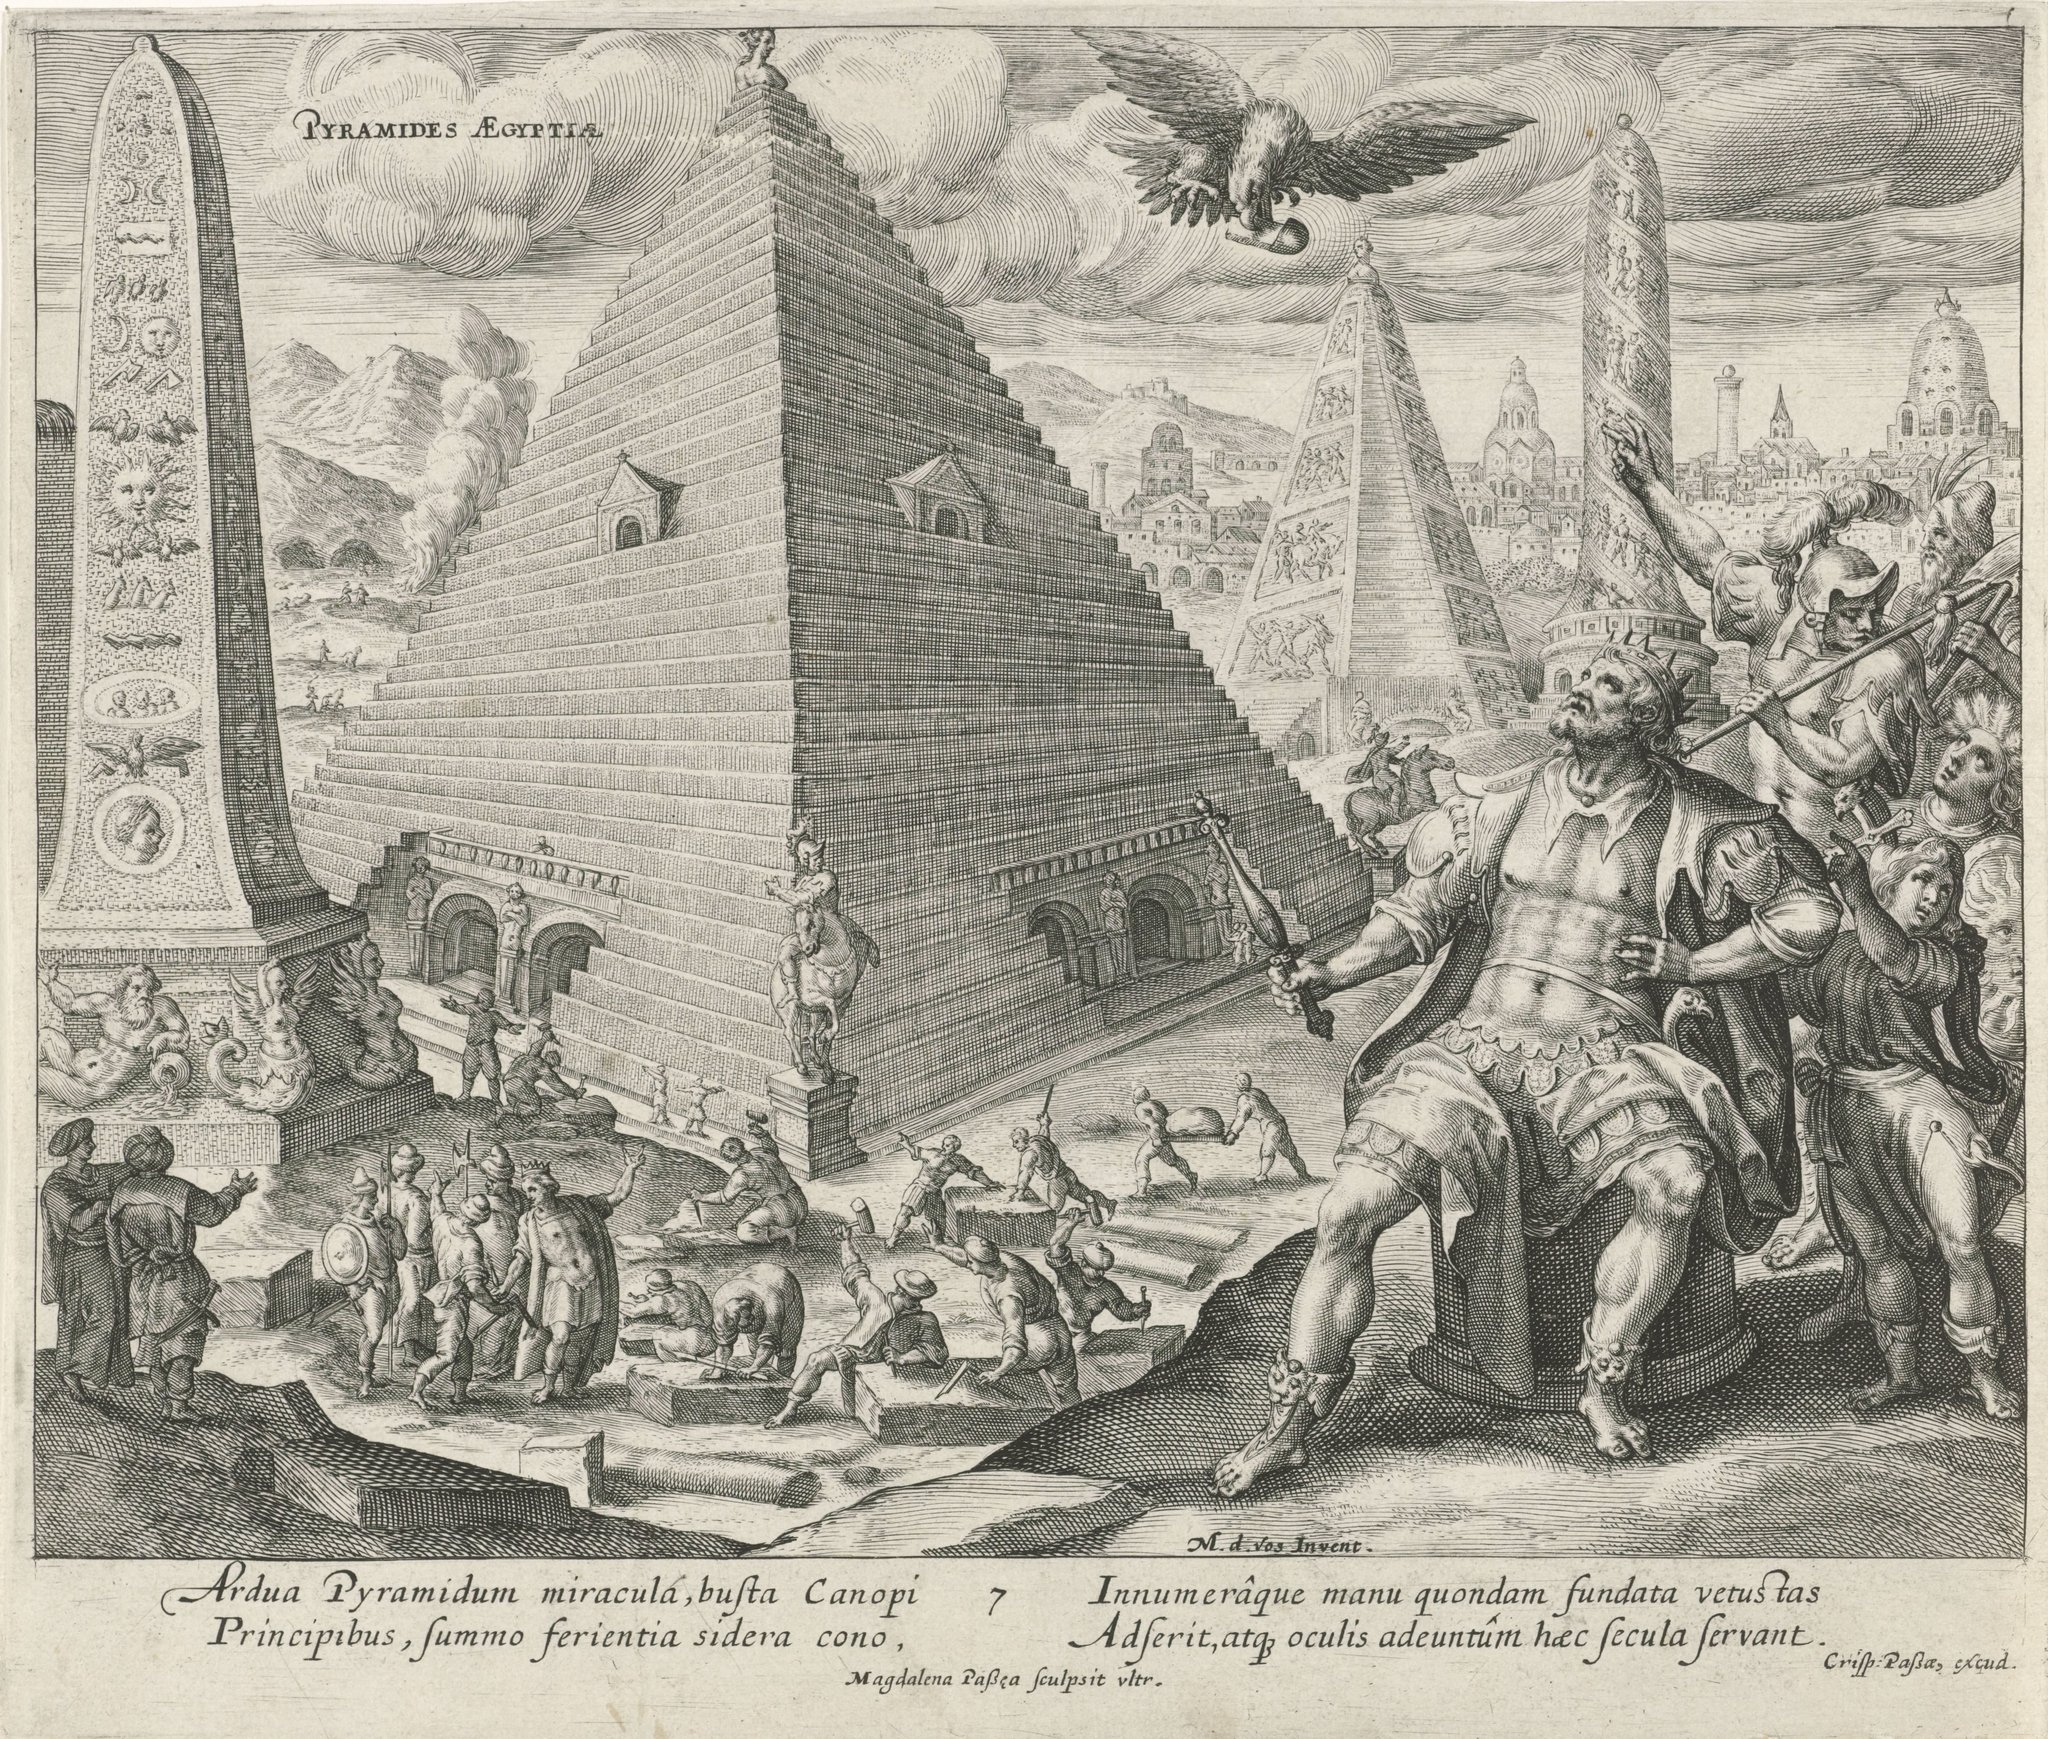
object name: print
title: The Pyramids of Egypt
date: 1614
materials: paper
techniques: engraving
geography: utrecht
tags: the courtesan rhodopis - love-affairs of person from classical history, egyptian pyramids (wonder of the world), slavery; serfs and enslaved persons, psammetichus, king of egypt, and the courtesan rhodopis; cupid assists her in putting on her sandal (while she was bathing one day an eagle carried away one of her sandals and dropped it near pharaoh, who started to look for its owner)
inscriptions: collector's mark: Lugt 2228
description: Magdalena de Passe was just fourteen years old when she made this contribution to the family workshop’s print production as a full-fledged engraver. They are the first engravings she signed and are part of a series of depictions of the seven wonders of the ancient world. In both prints, De Passe created depth by engraving the background lighter than the foreground.